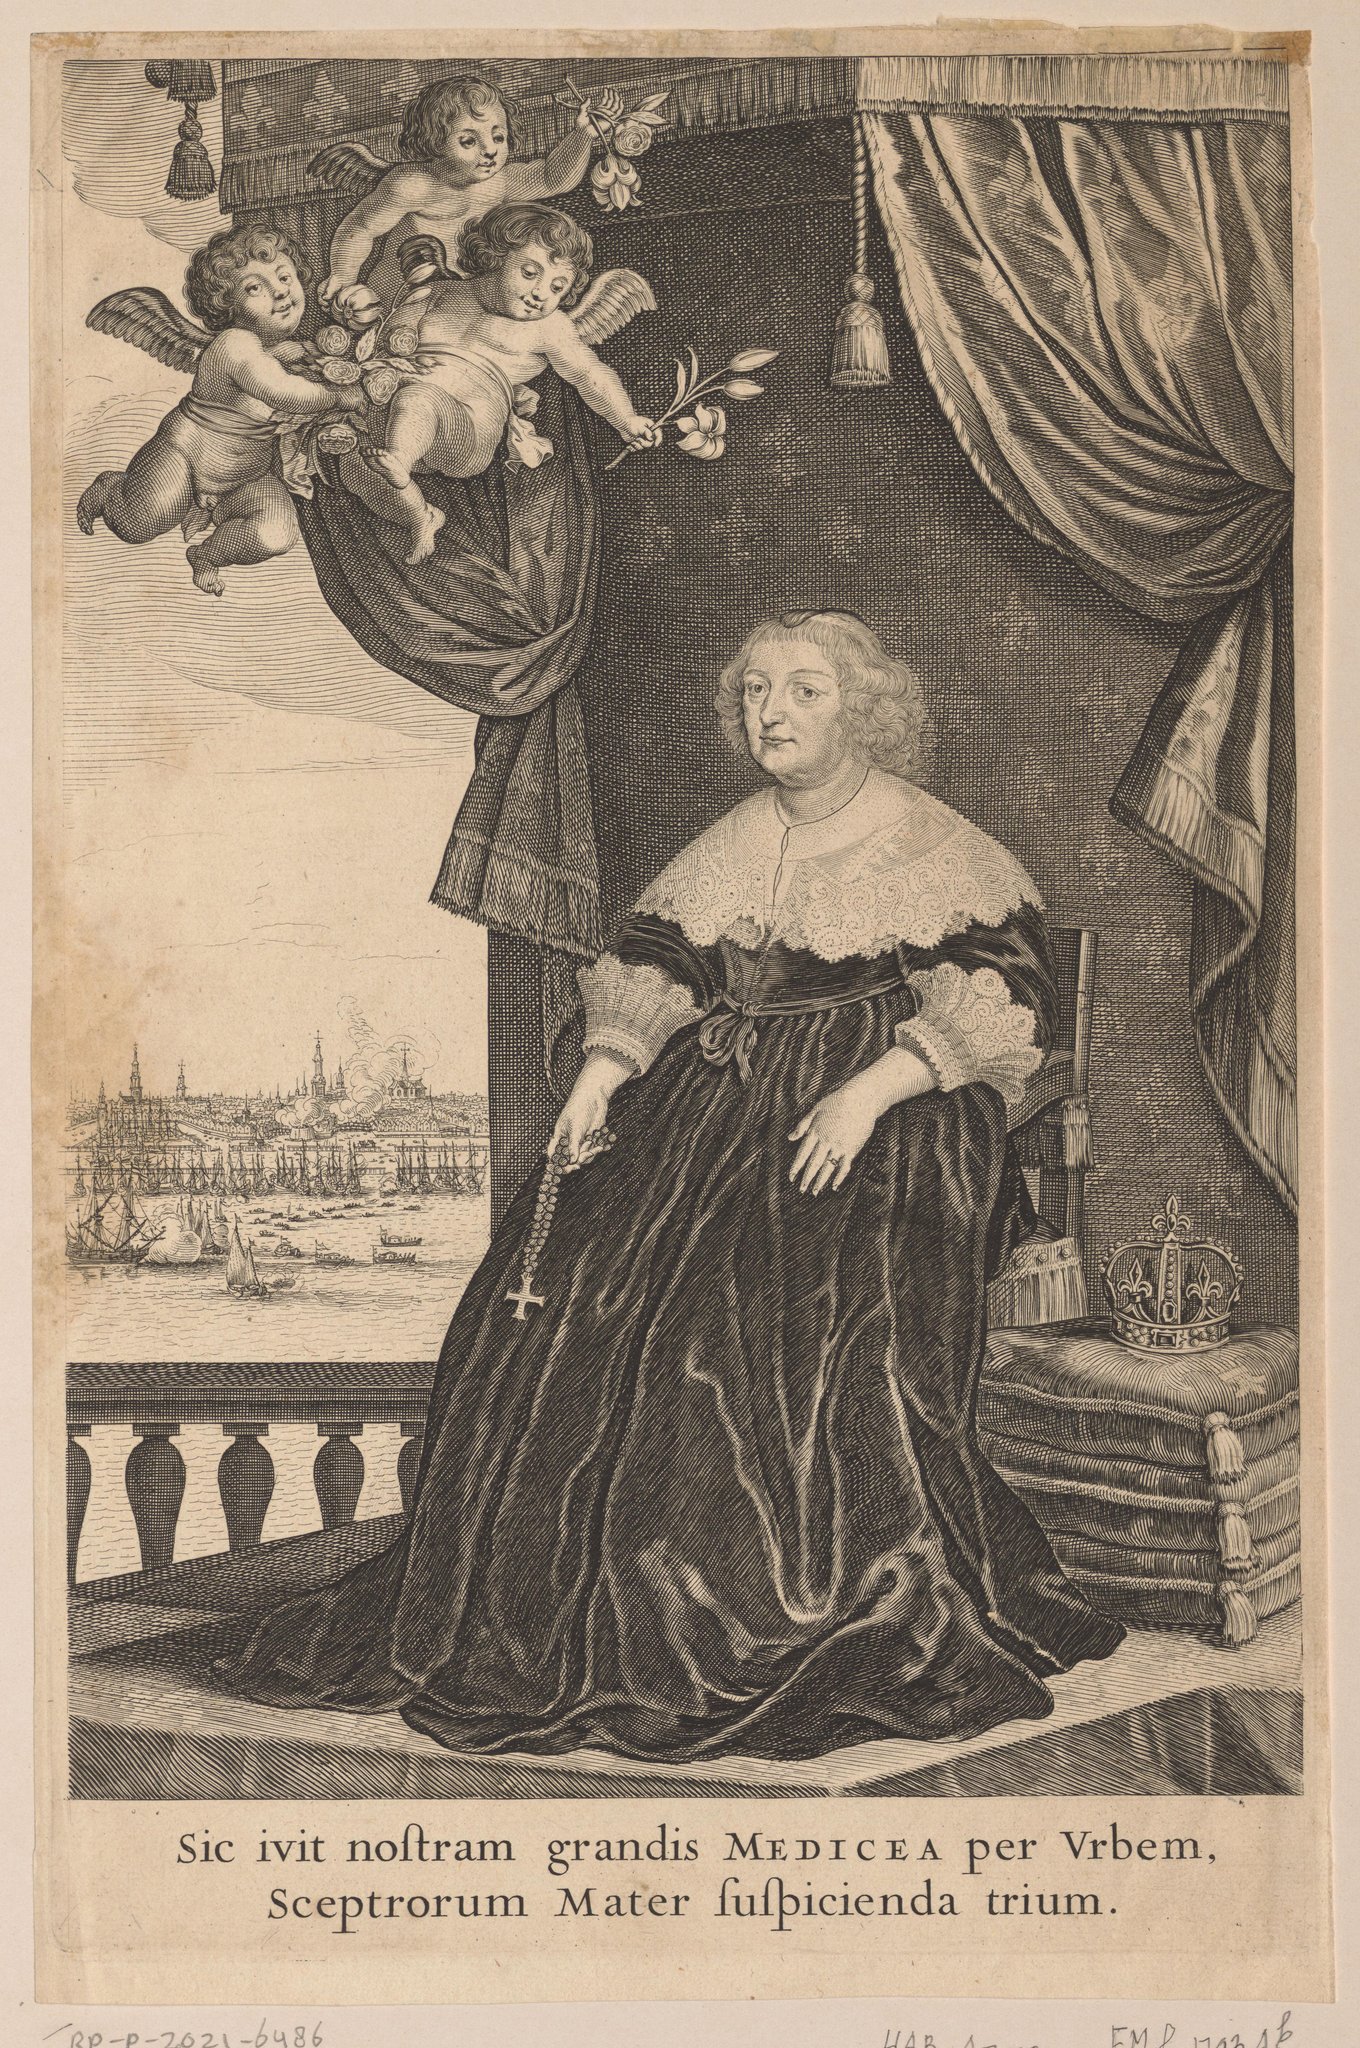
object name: print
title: Portret van Maria de' Medici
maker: salomon savery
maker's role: print maker, publisher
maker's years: 1594-1683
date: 1638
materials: paper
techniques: engraving, etching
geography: amsterdam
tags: print maker, maria de' medici, city-view, and landscape with man-made constructions, historical persons - bb - woman, crown (symbol of sovereignty) - bb - female ruler, cupids: 'amores', 'amoretti', 'putti', amsterdam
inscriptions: inscription: ‘Coll=Franken’, collector's mark: Lugt 2228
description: Prent waarschijnlijk uit: Barlaeus, Caspar. Medicea hospes, sive descriptio publicae gratulationis, qua... Mariam de Medicis, excepit senatus populusque Amstelodamensis. Amsterdam: Johan en Cornelis Blaeu, 1638.